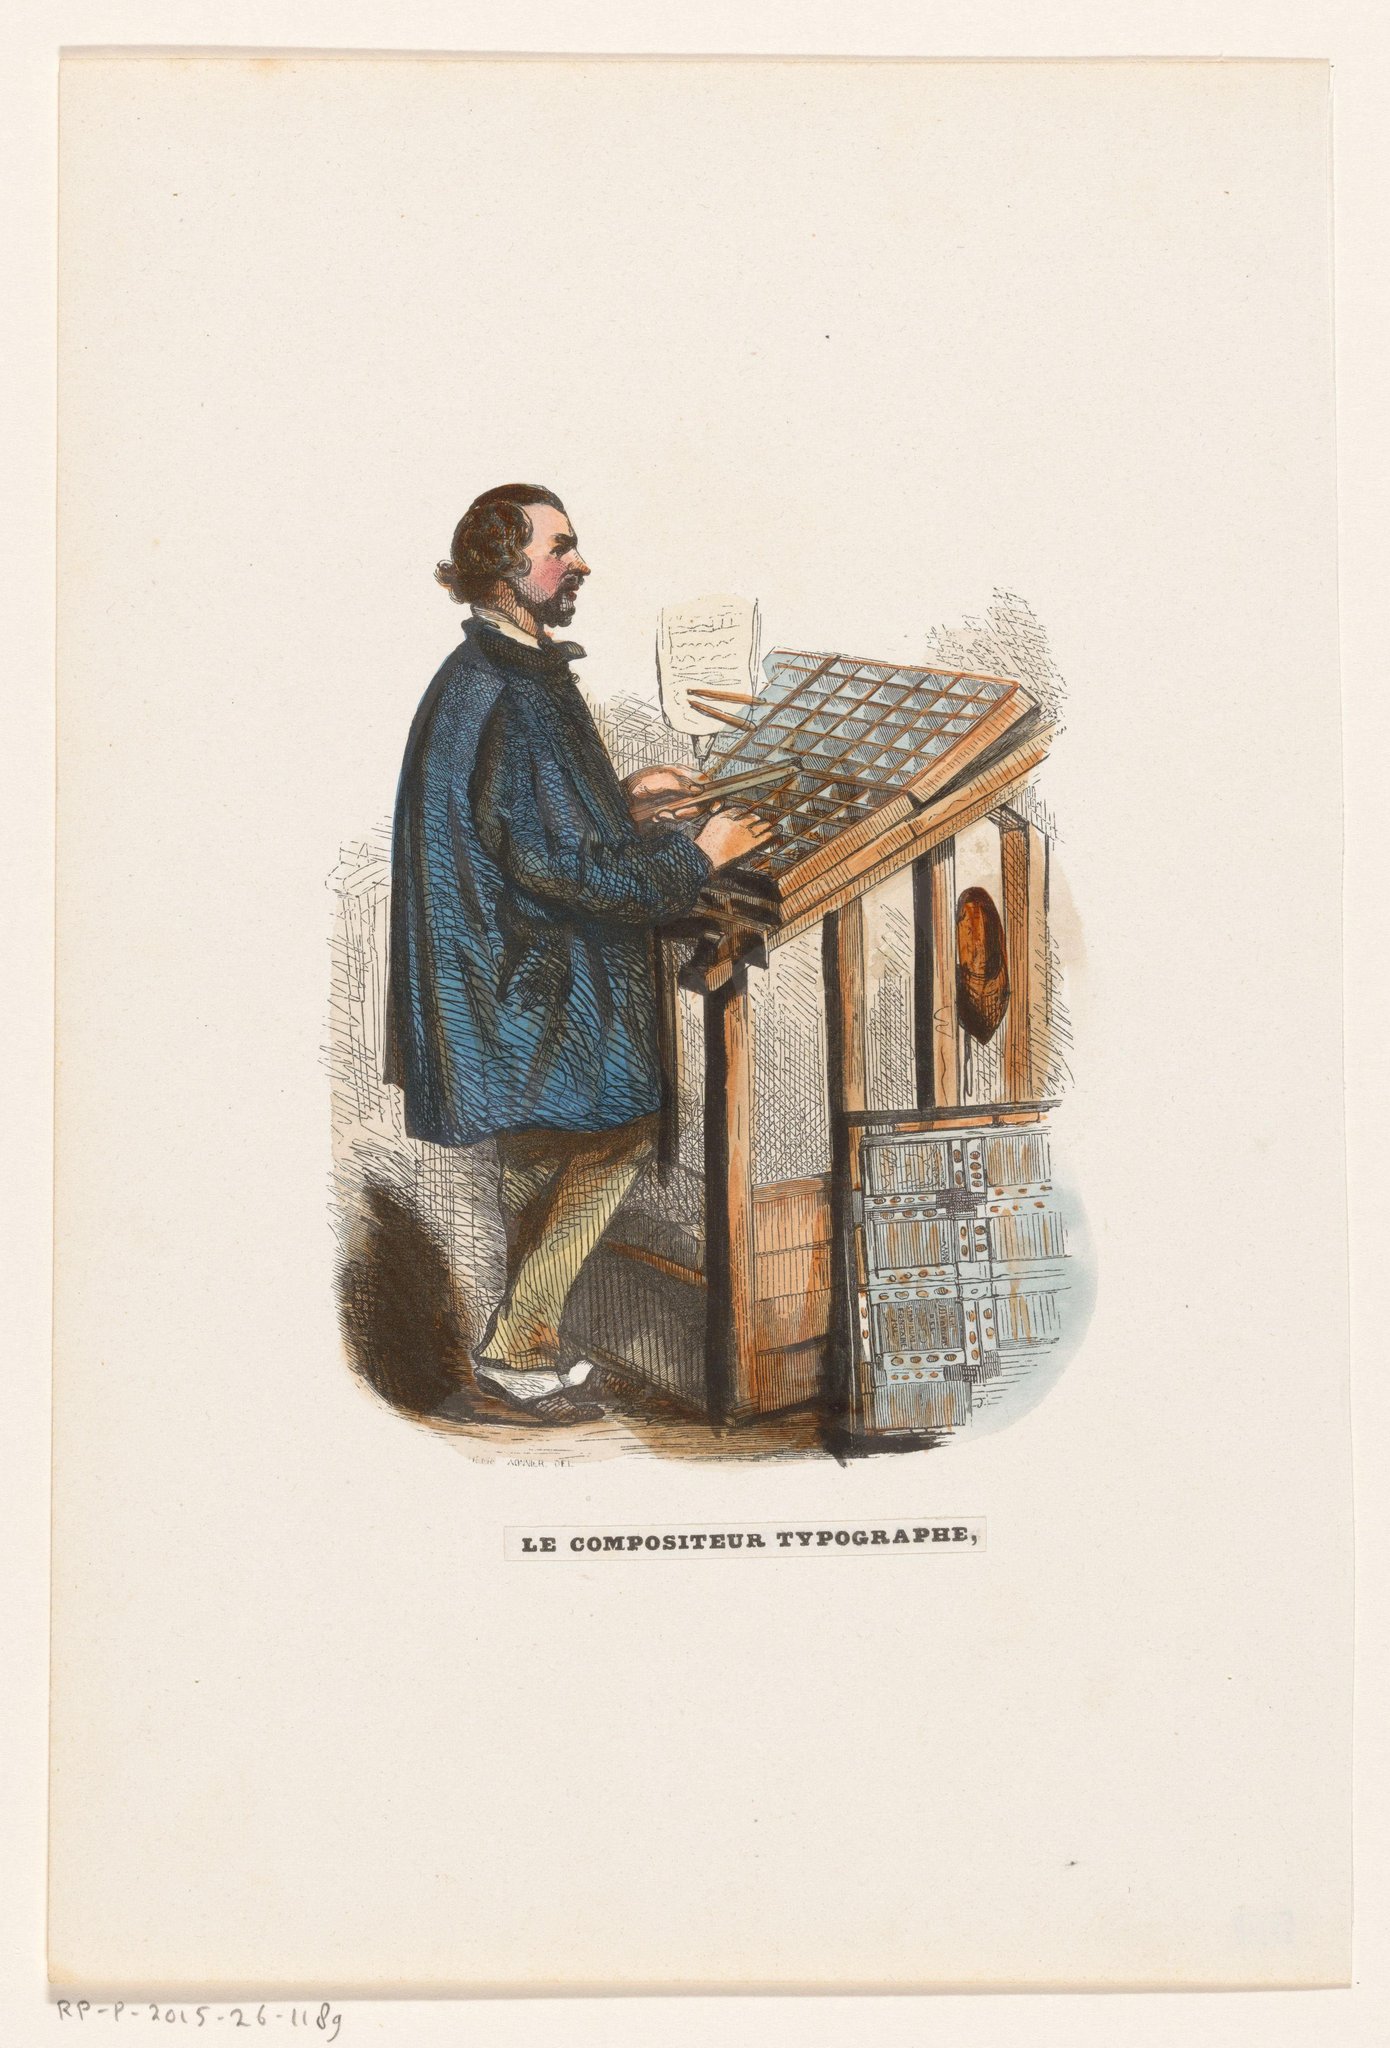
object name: book illustration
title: Le compositeur typographe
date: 1841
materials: paper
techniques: hand coloring, engraving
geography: paris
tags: tools, implements of printer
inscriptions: collector's mark: Lugt 4779, collector's mark: Lugt 2228, collector's mark: Lugt 4780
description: Prent ook gebruikt in: Les français peints par eux-mêmes: encyclopédie morale du dix-neuvième siècle. Parijs: L. Curmer, 1841, dl. 2, tussen p. 264-265.